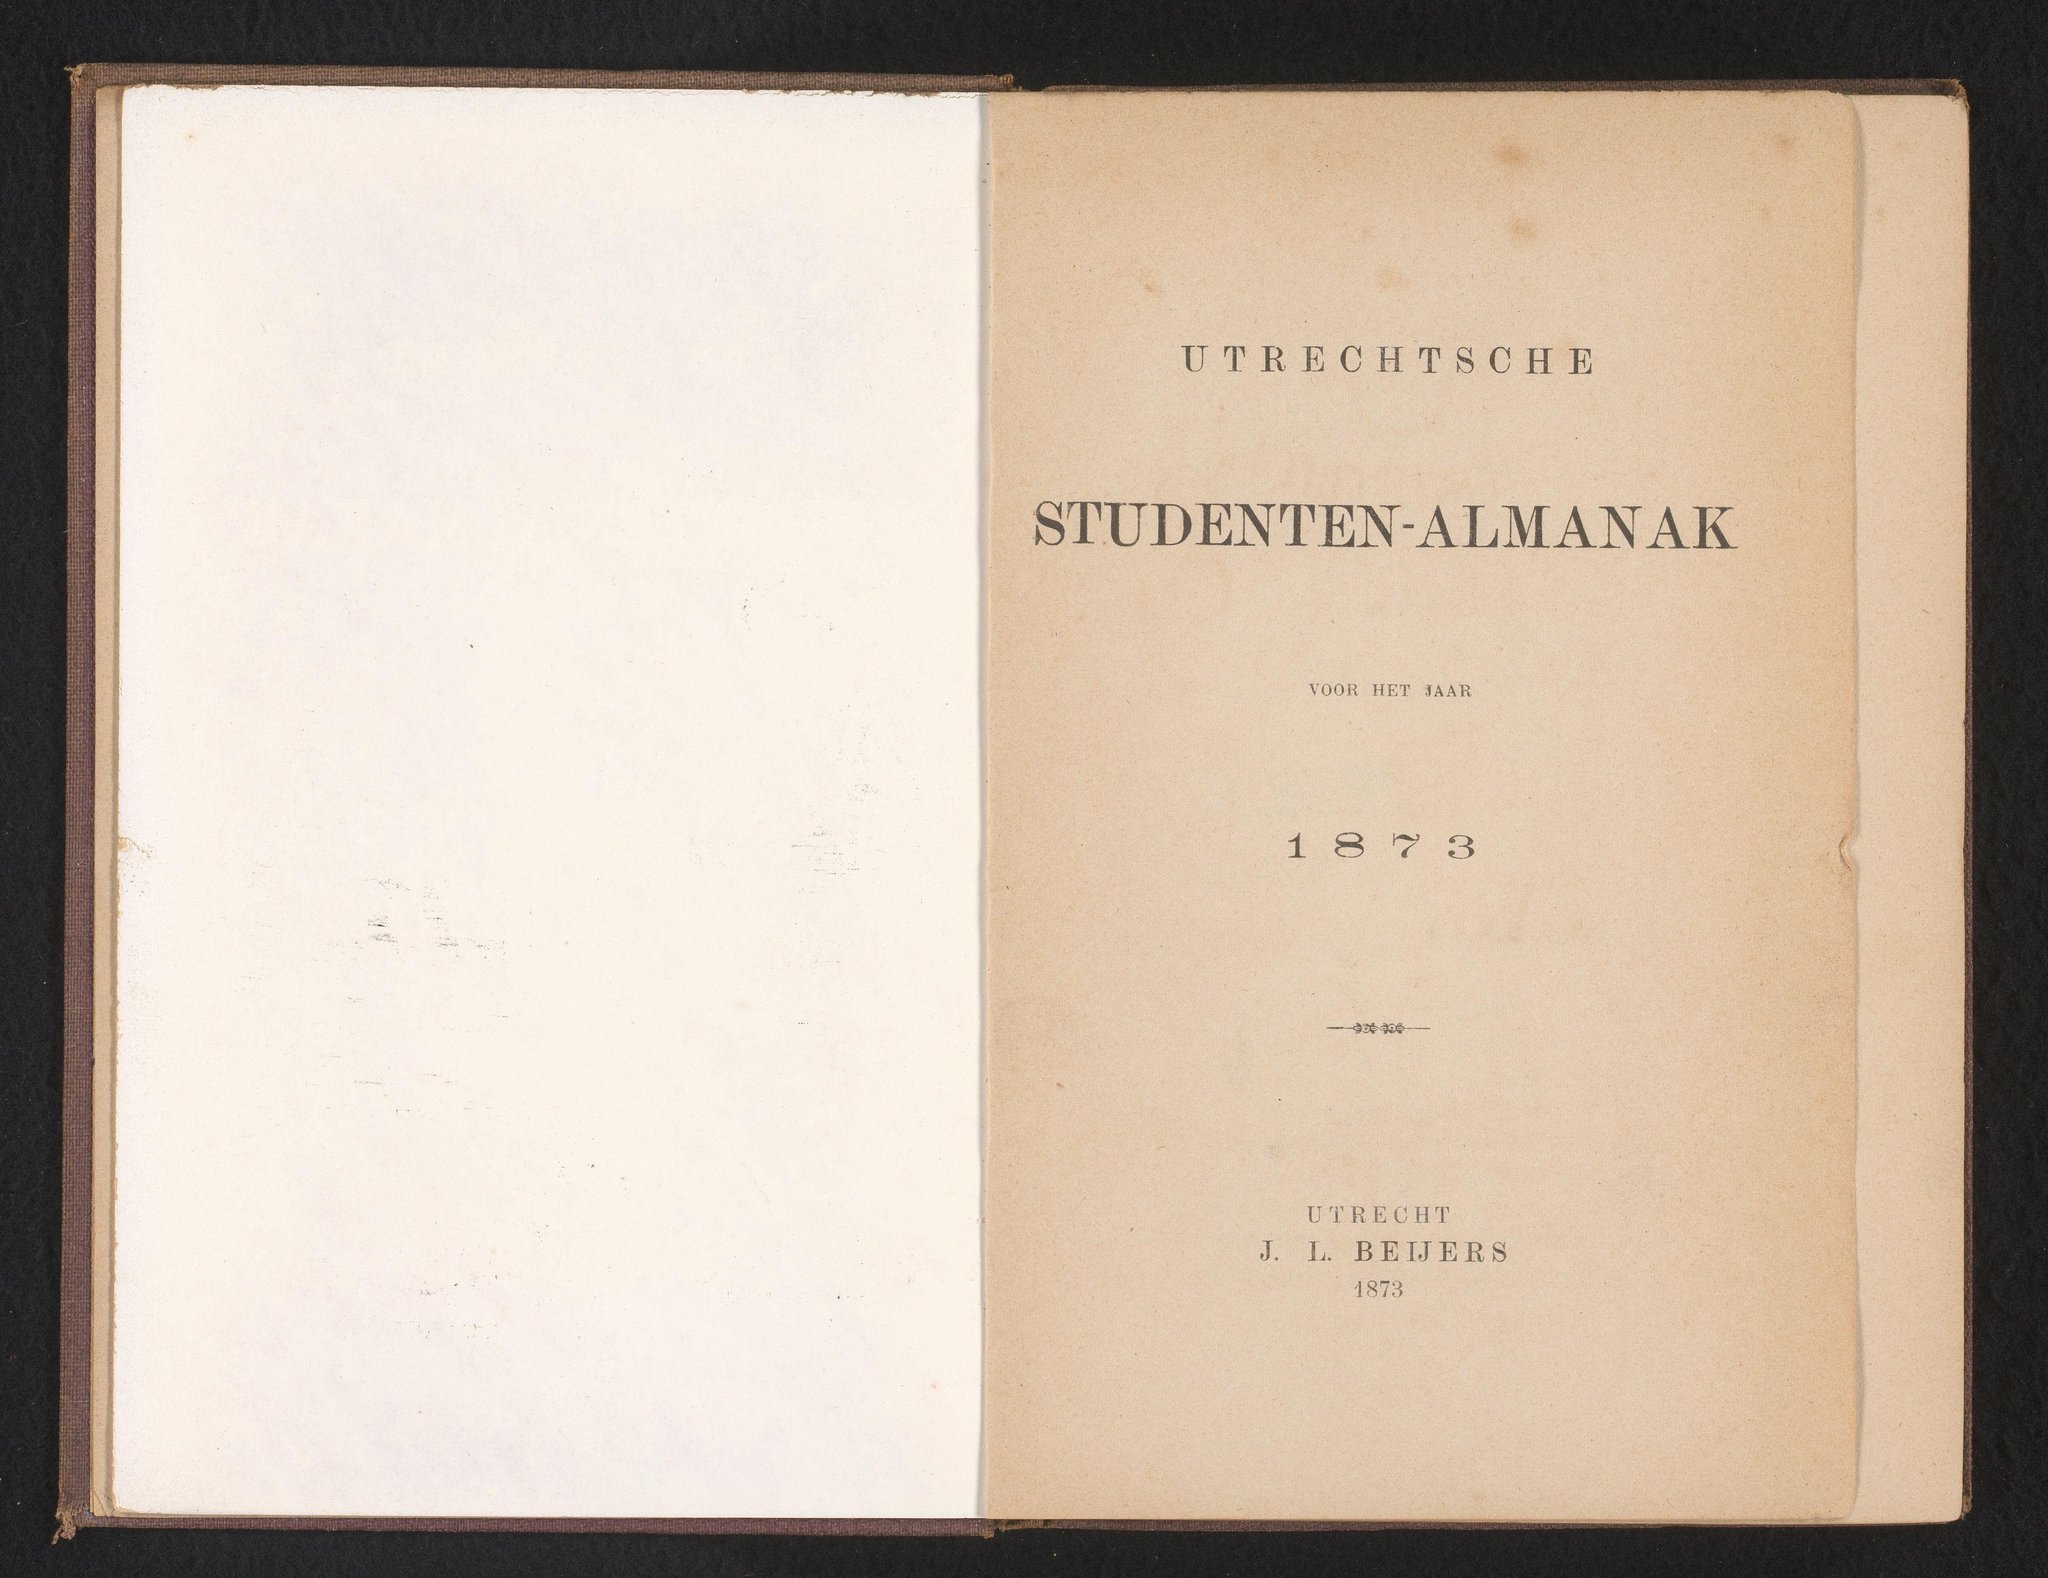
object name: book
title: Utrechtsche studenten-almanak voor het jaar 1873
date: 1873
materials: cardboard, linen, paper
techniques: albumen print, letterpress printing, lithograph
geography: utrecht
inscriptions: number: ‘3057’